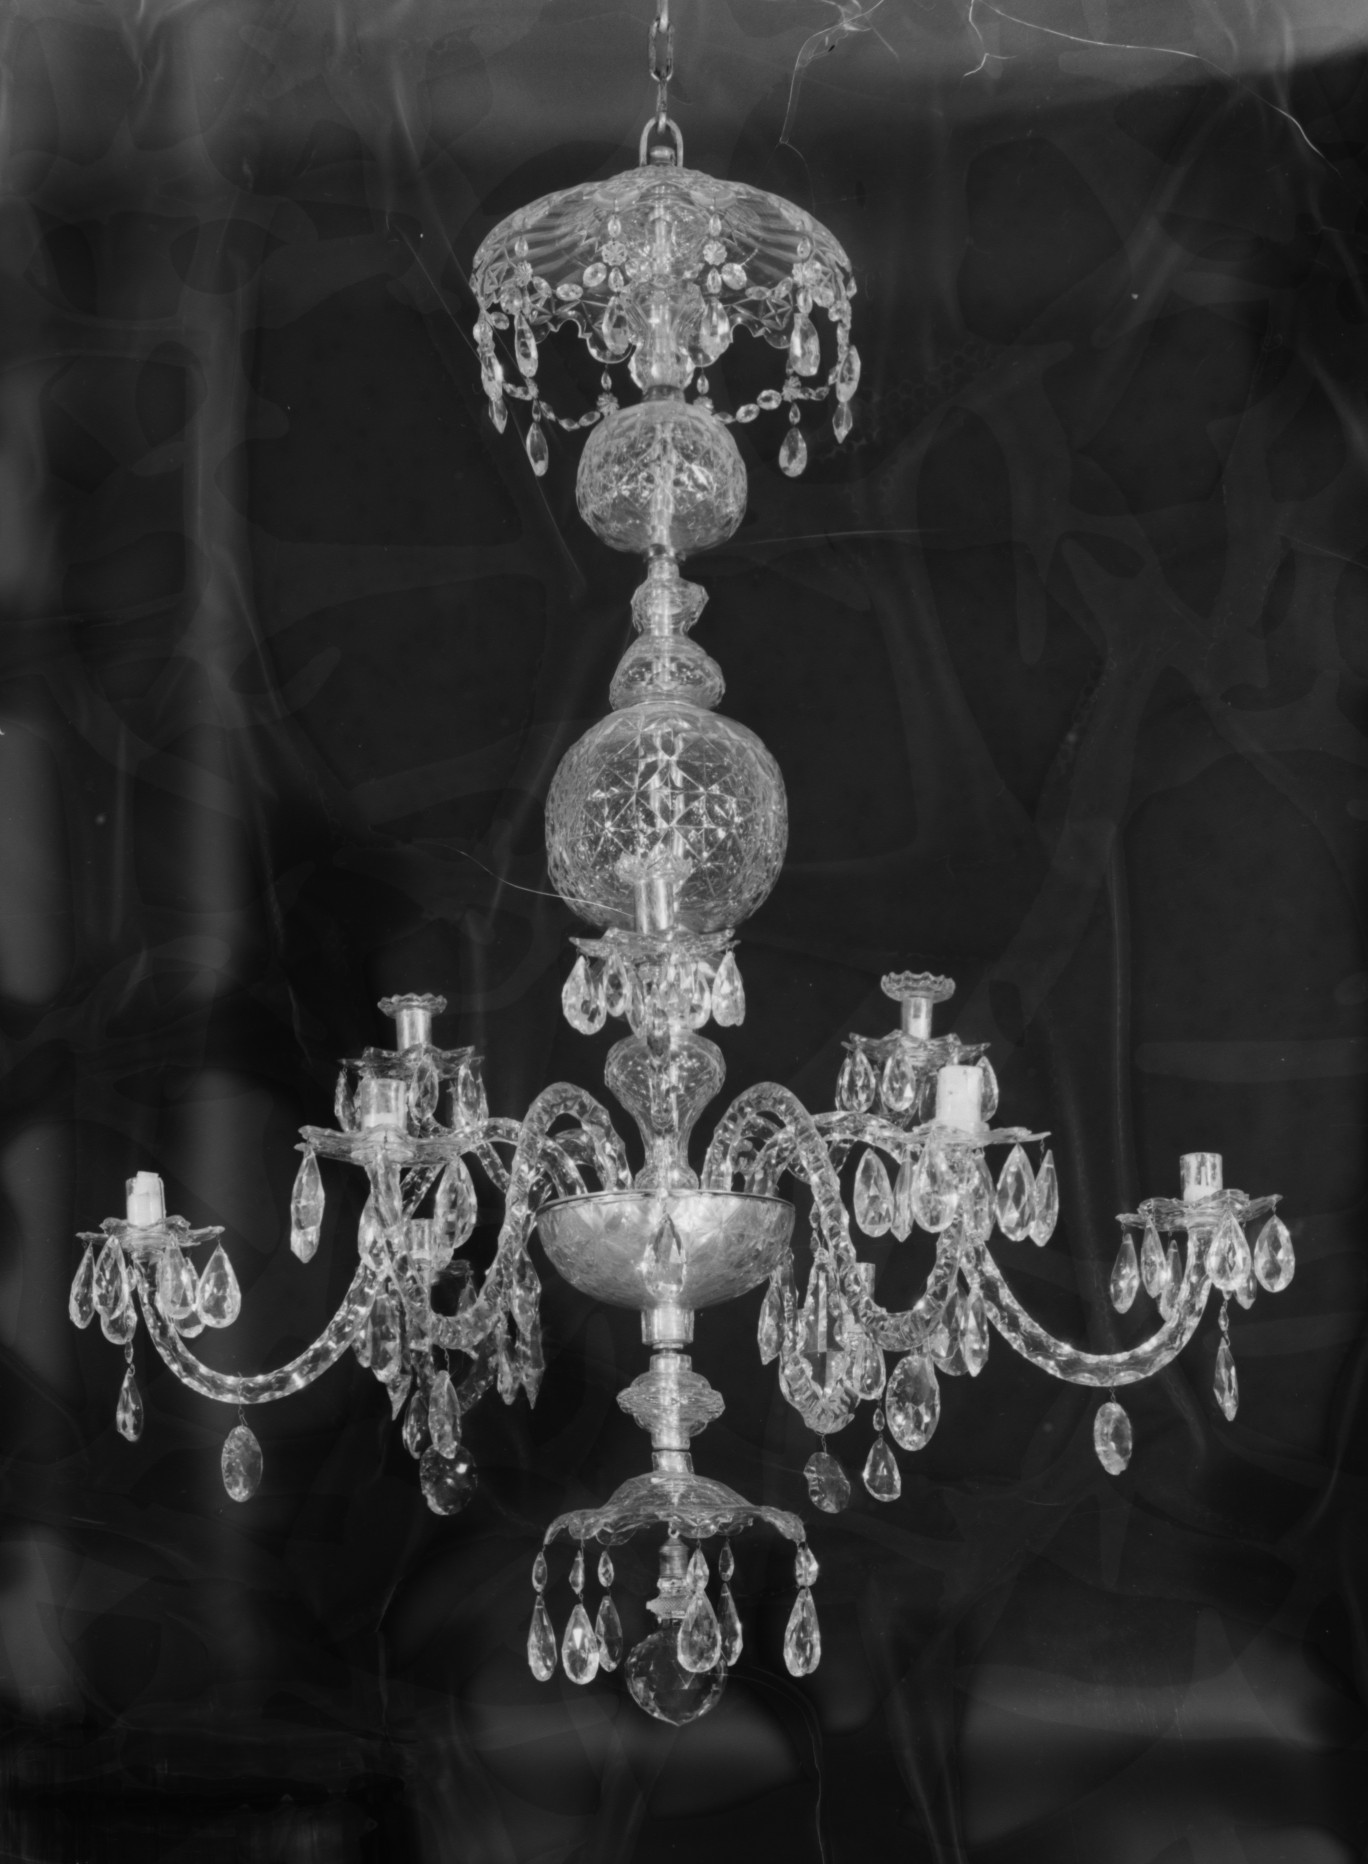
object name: chandelier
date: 1775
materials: glass